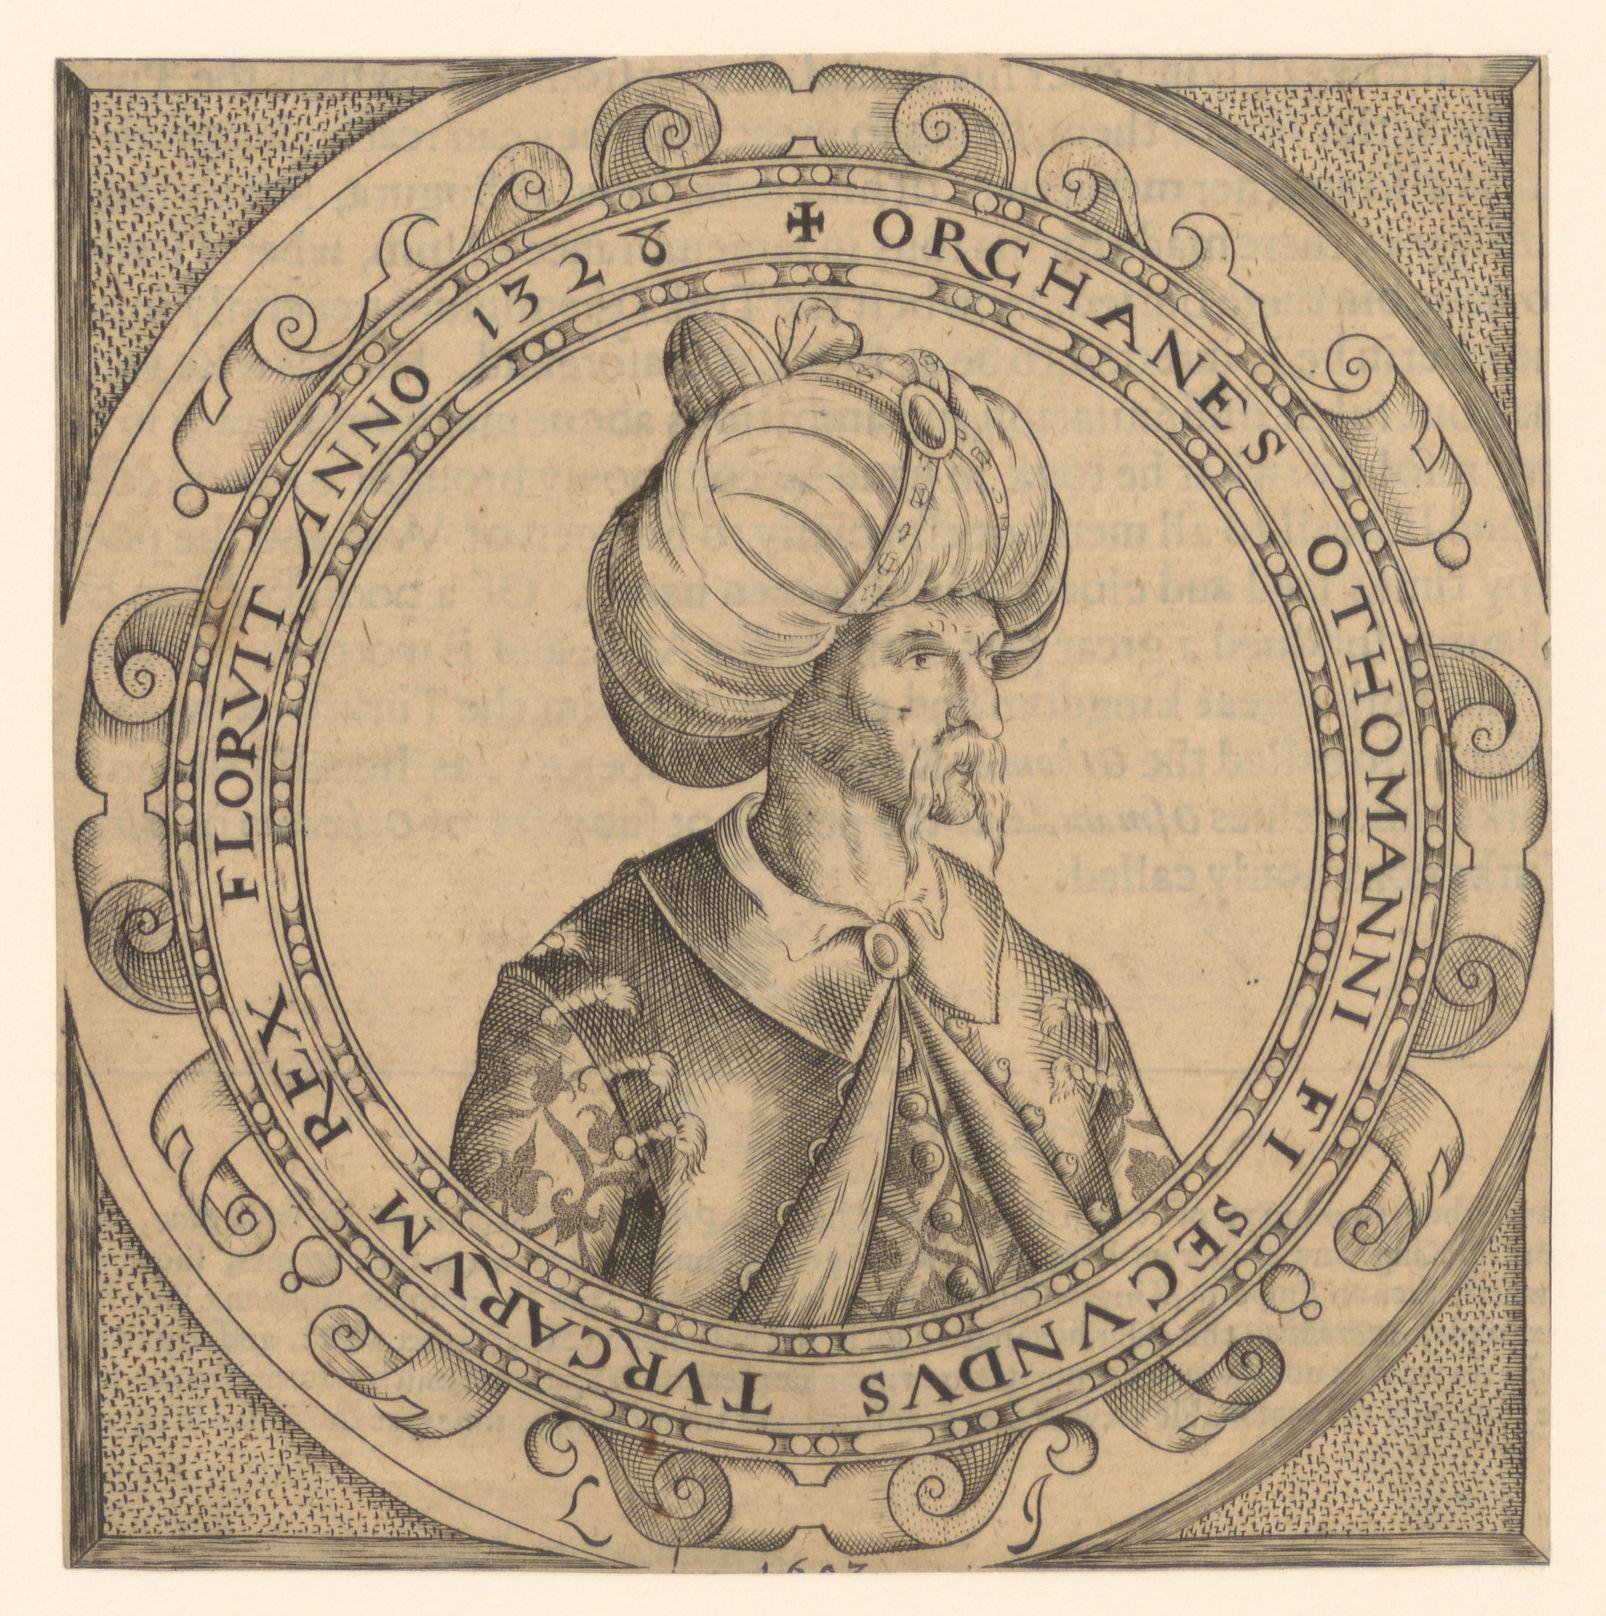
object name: book illustration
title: Portret van sultan Orhan I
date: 1603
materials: paper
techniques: engraving, letterpress printing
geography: london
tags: historical persons, ruler, sovereign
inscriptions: collector's mark: Lugt 2228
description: Prent gebruikt in: Knolles, Richard. The lives of the Othoman Kings and Emperors (...). Londen: Adam Islip, 1603. Prent ook gebruikt in: Knolles, Richard. The Generall Historie of the Turkes from the First Beginning of that Nation to the Rising of the Othoman Familie. Londen: Adam Islip, 1603.